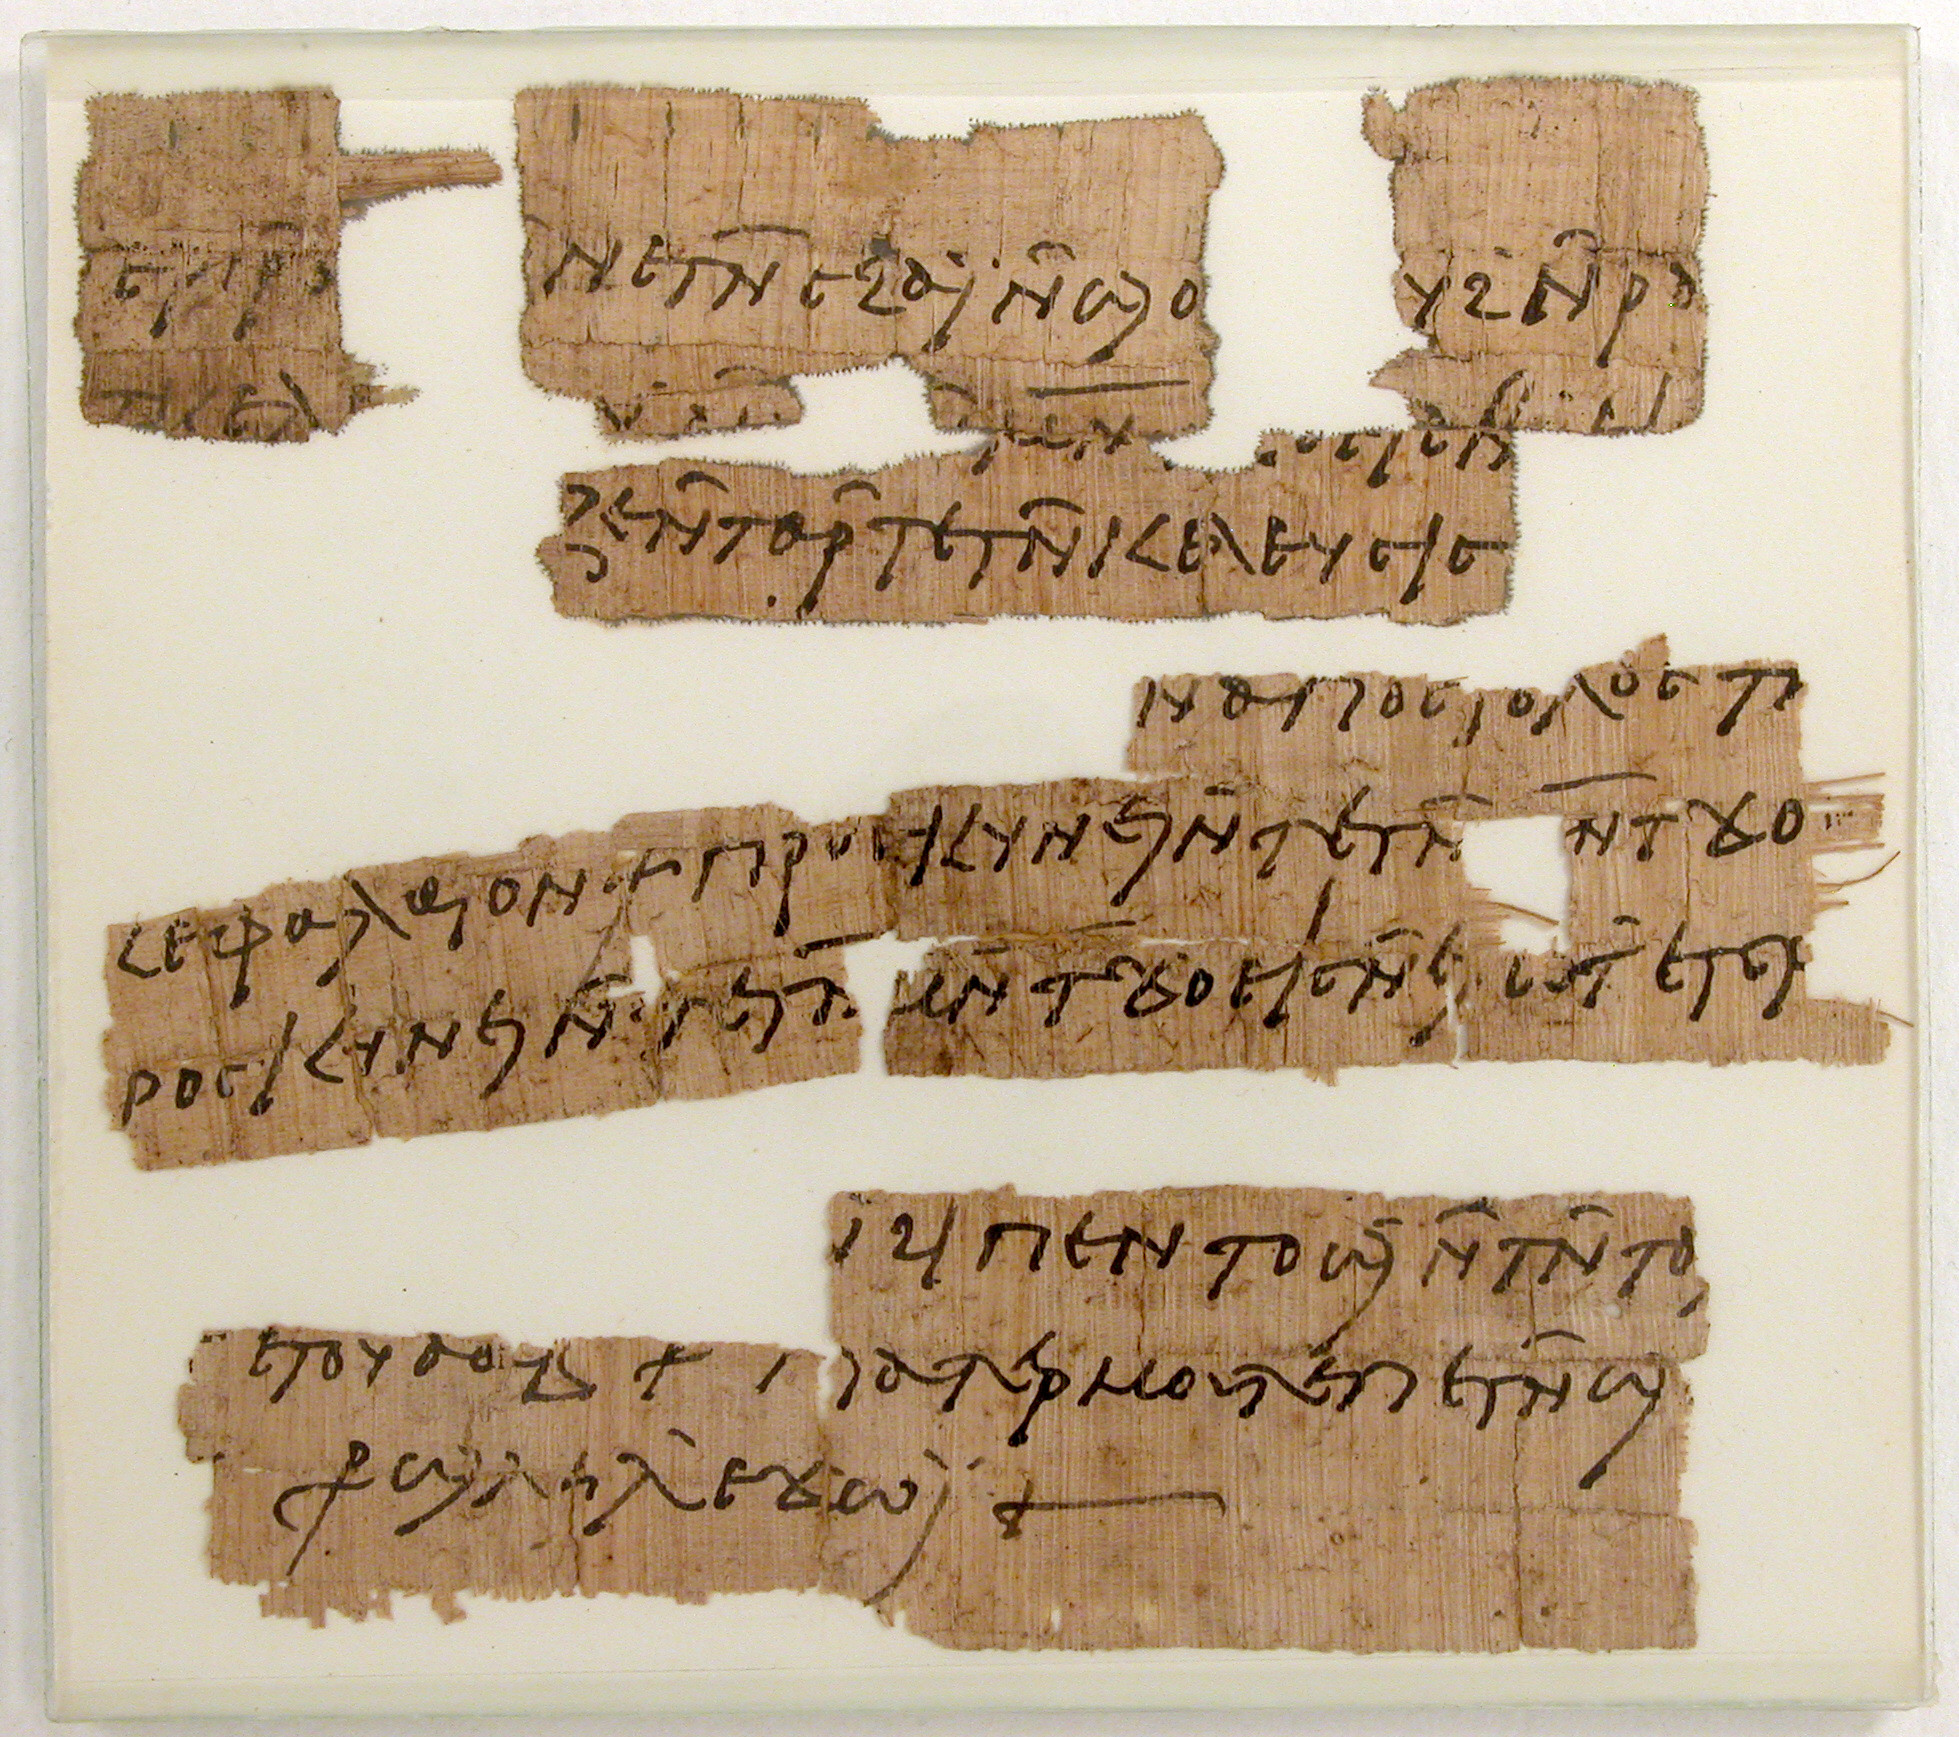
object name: fragment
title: Papyri Fragments of a Letter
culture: coptic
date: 601-700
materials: ink, papyrus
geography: egypt